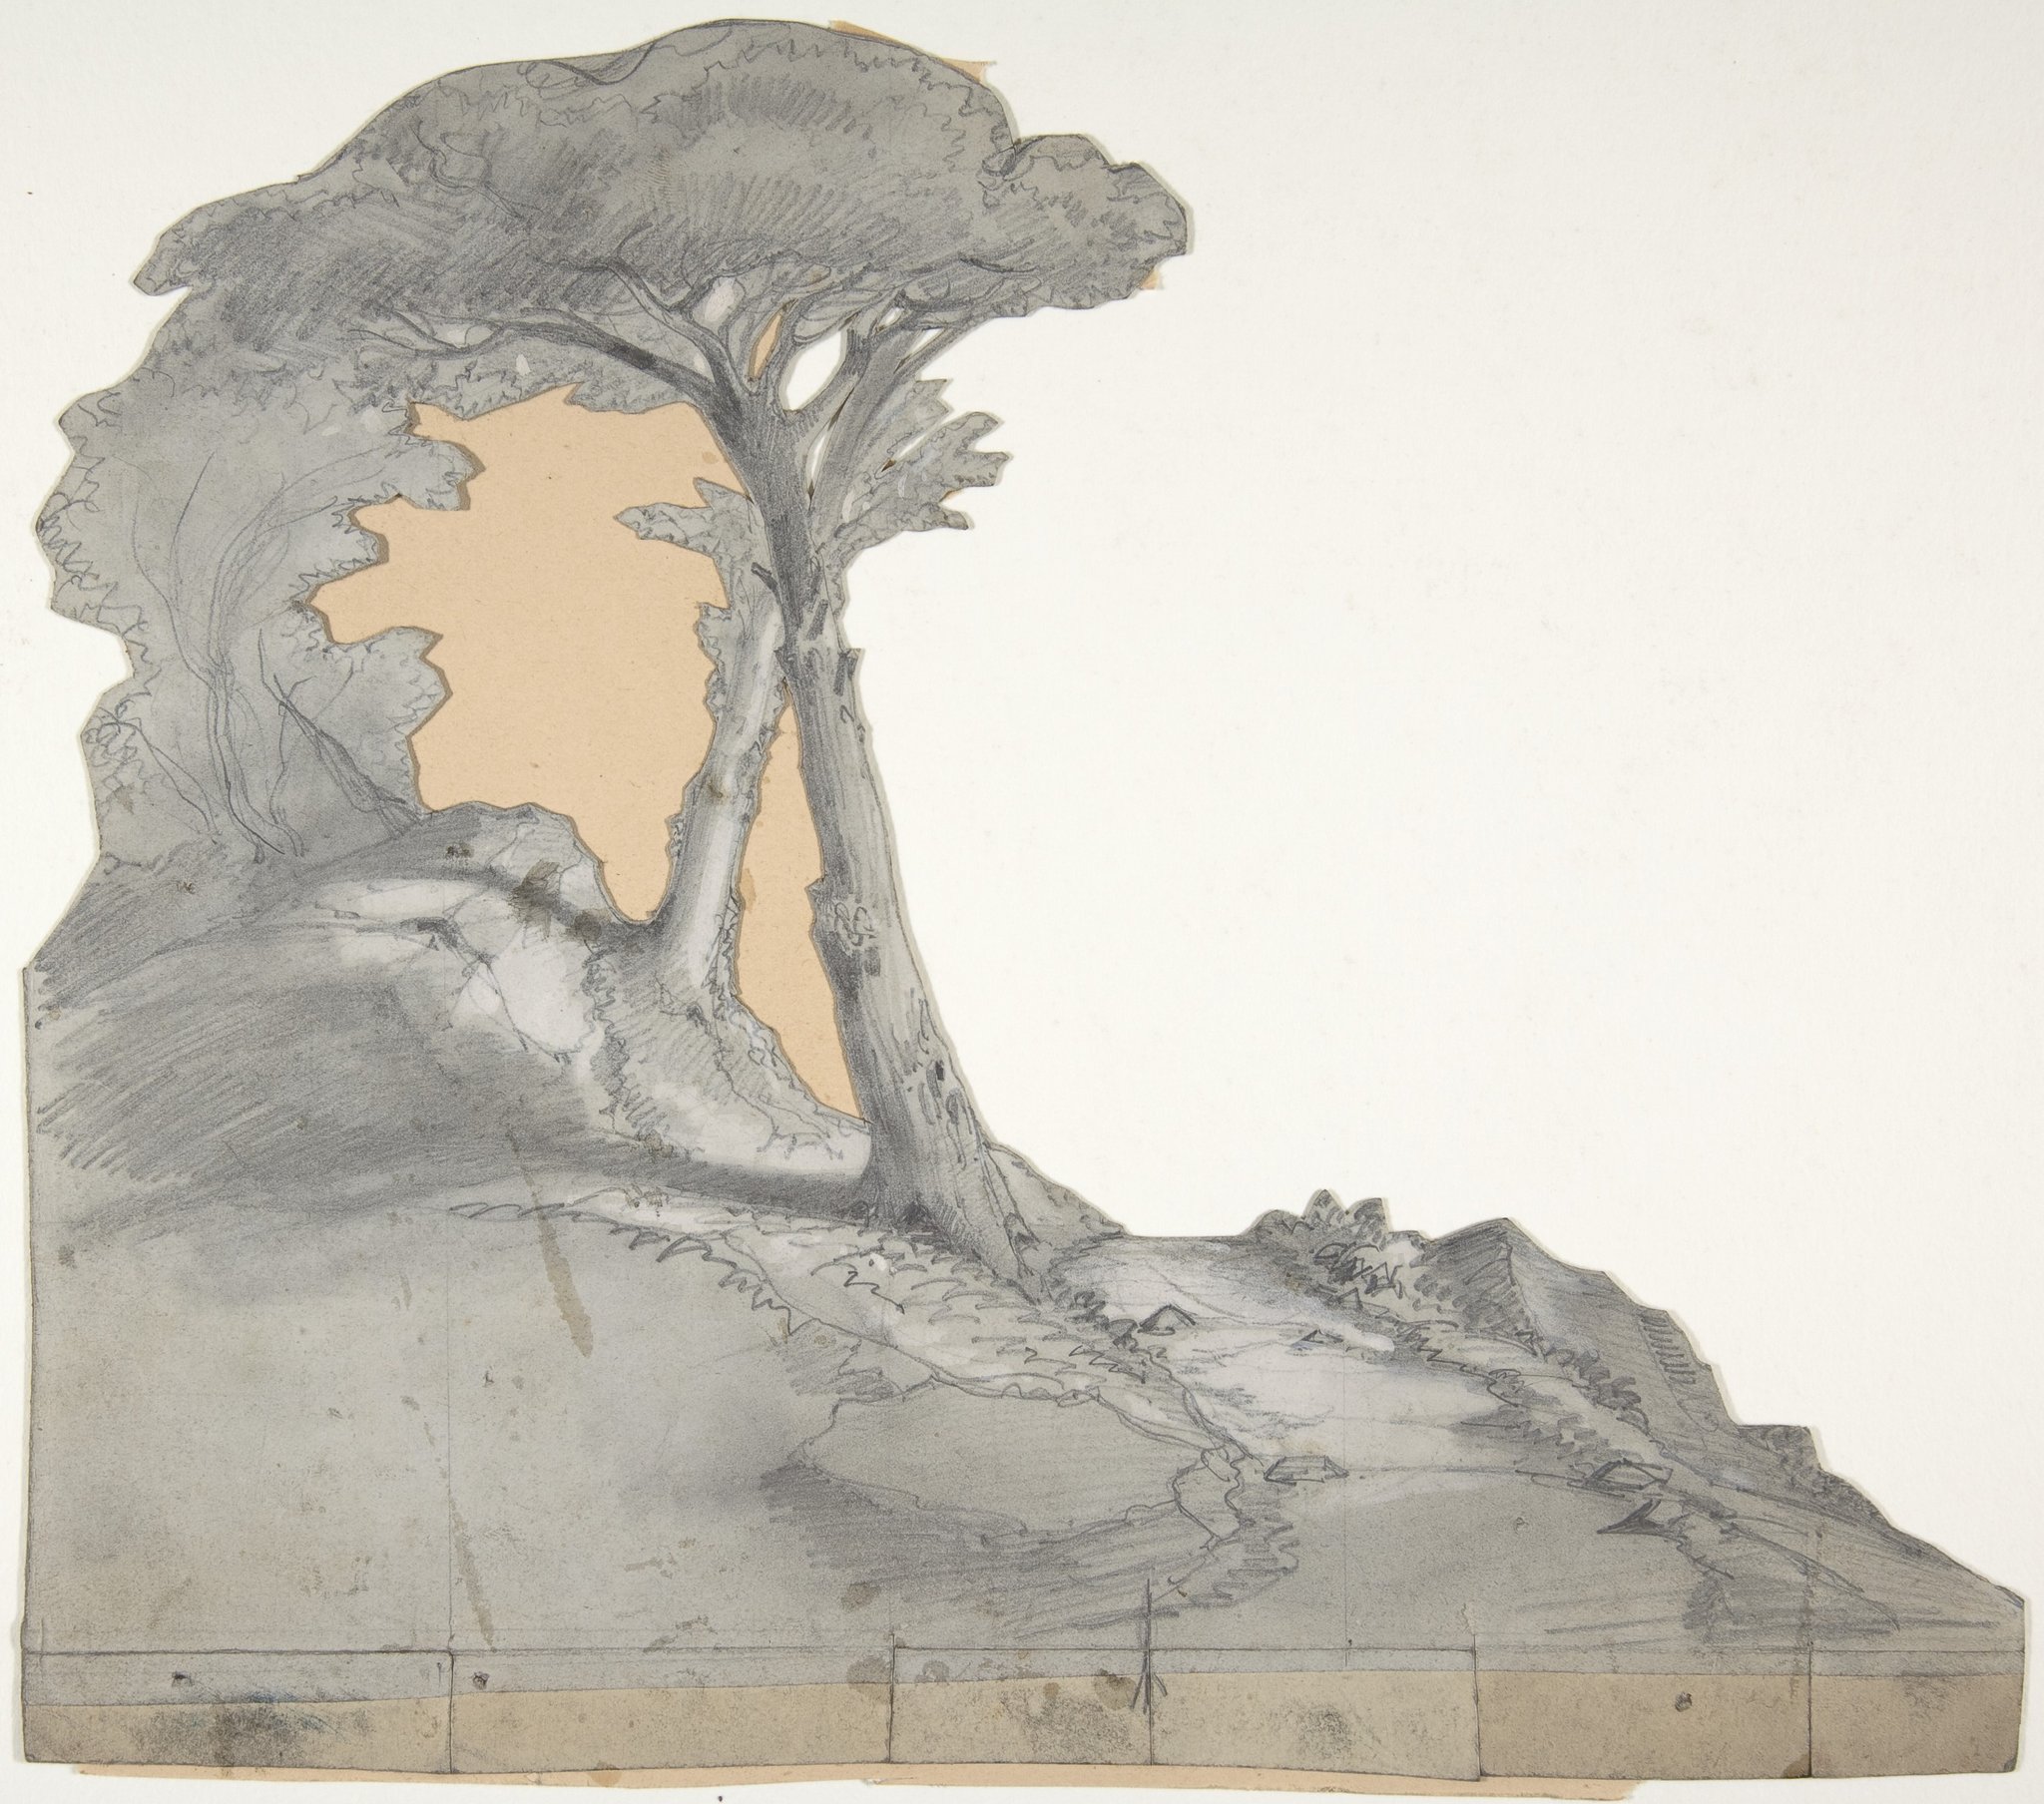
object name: drawing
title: Design for a Stage Set at the Opéra, Paris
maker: eugène cicéri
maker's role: artist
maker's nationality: french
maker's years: 1813-1890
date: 1825-1890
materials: graphite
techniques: heightening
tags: trees,stage design